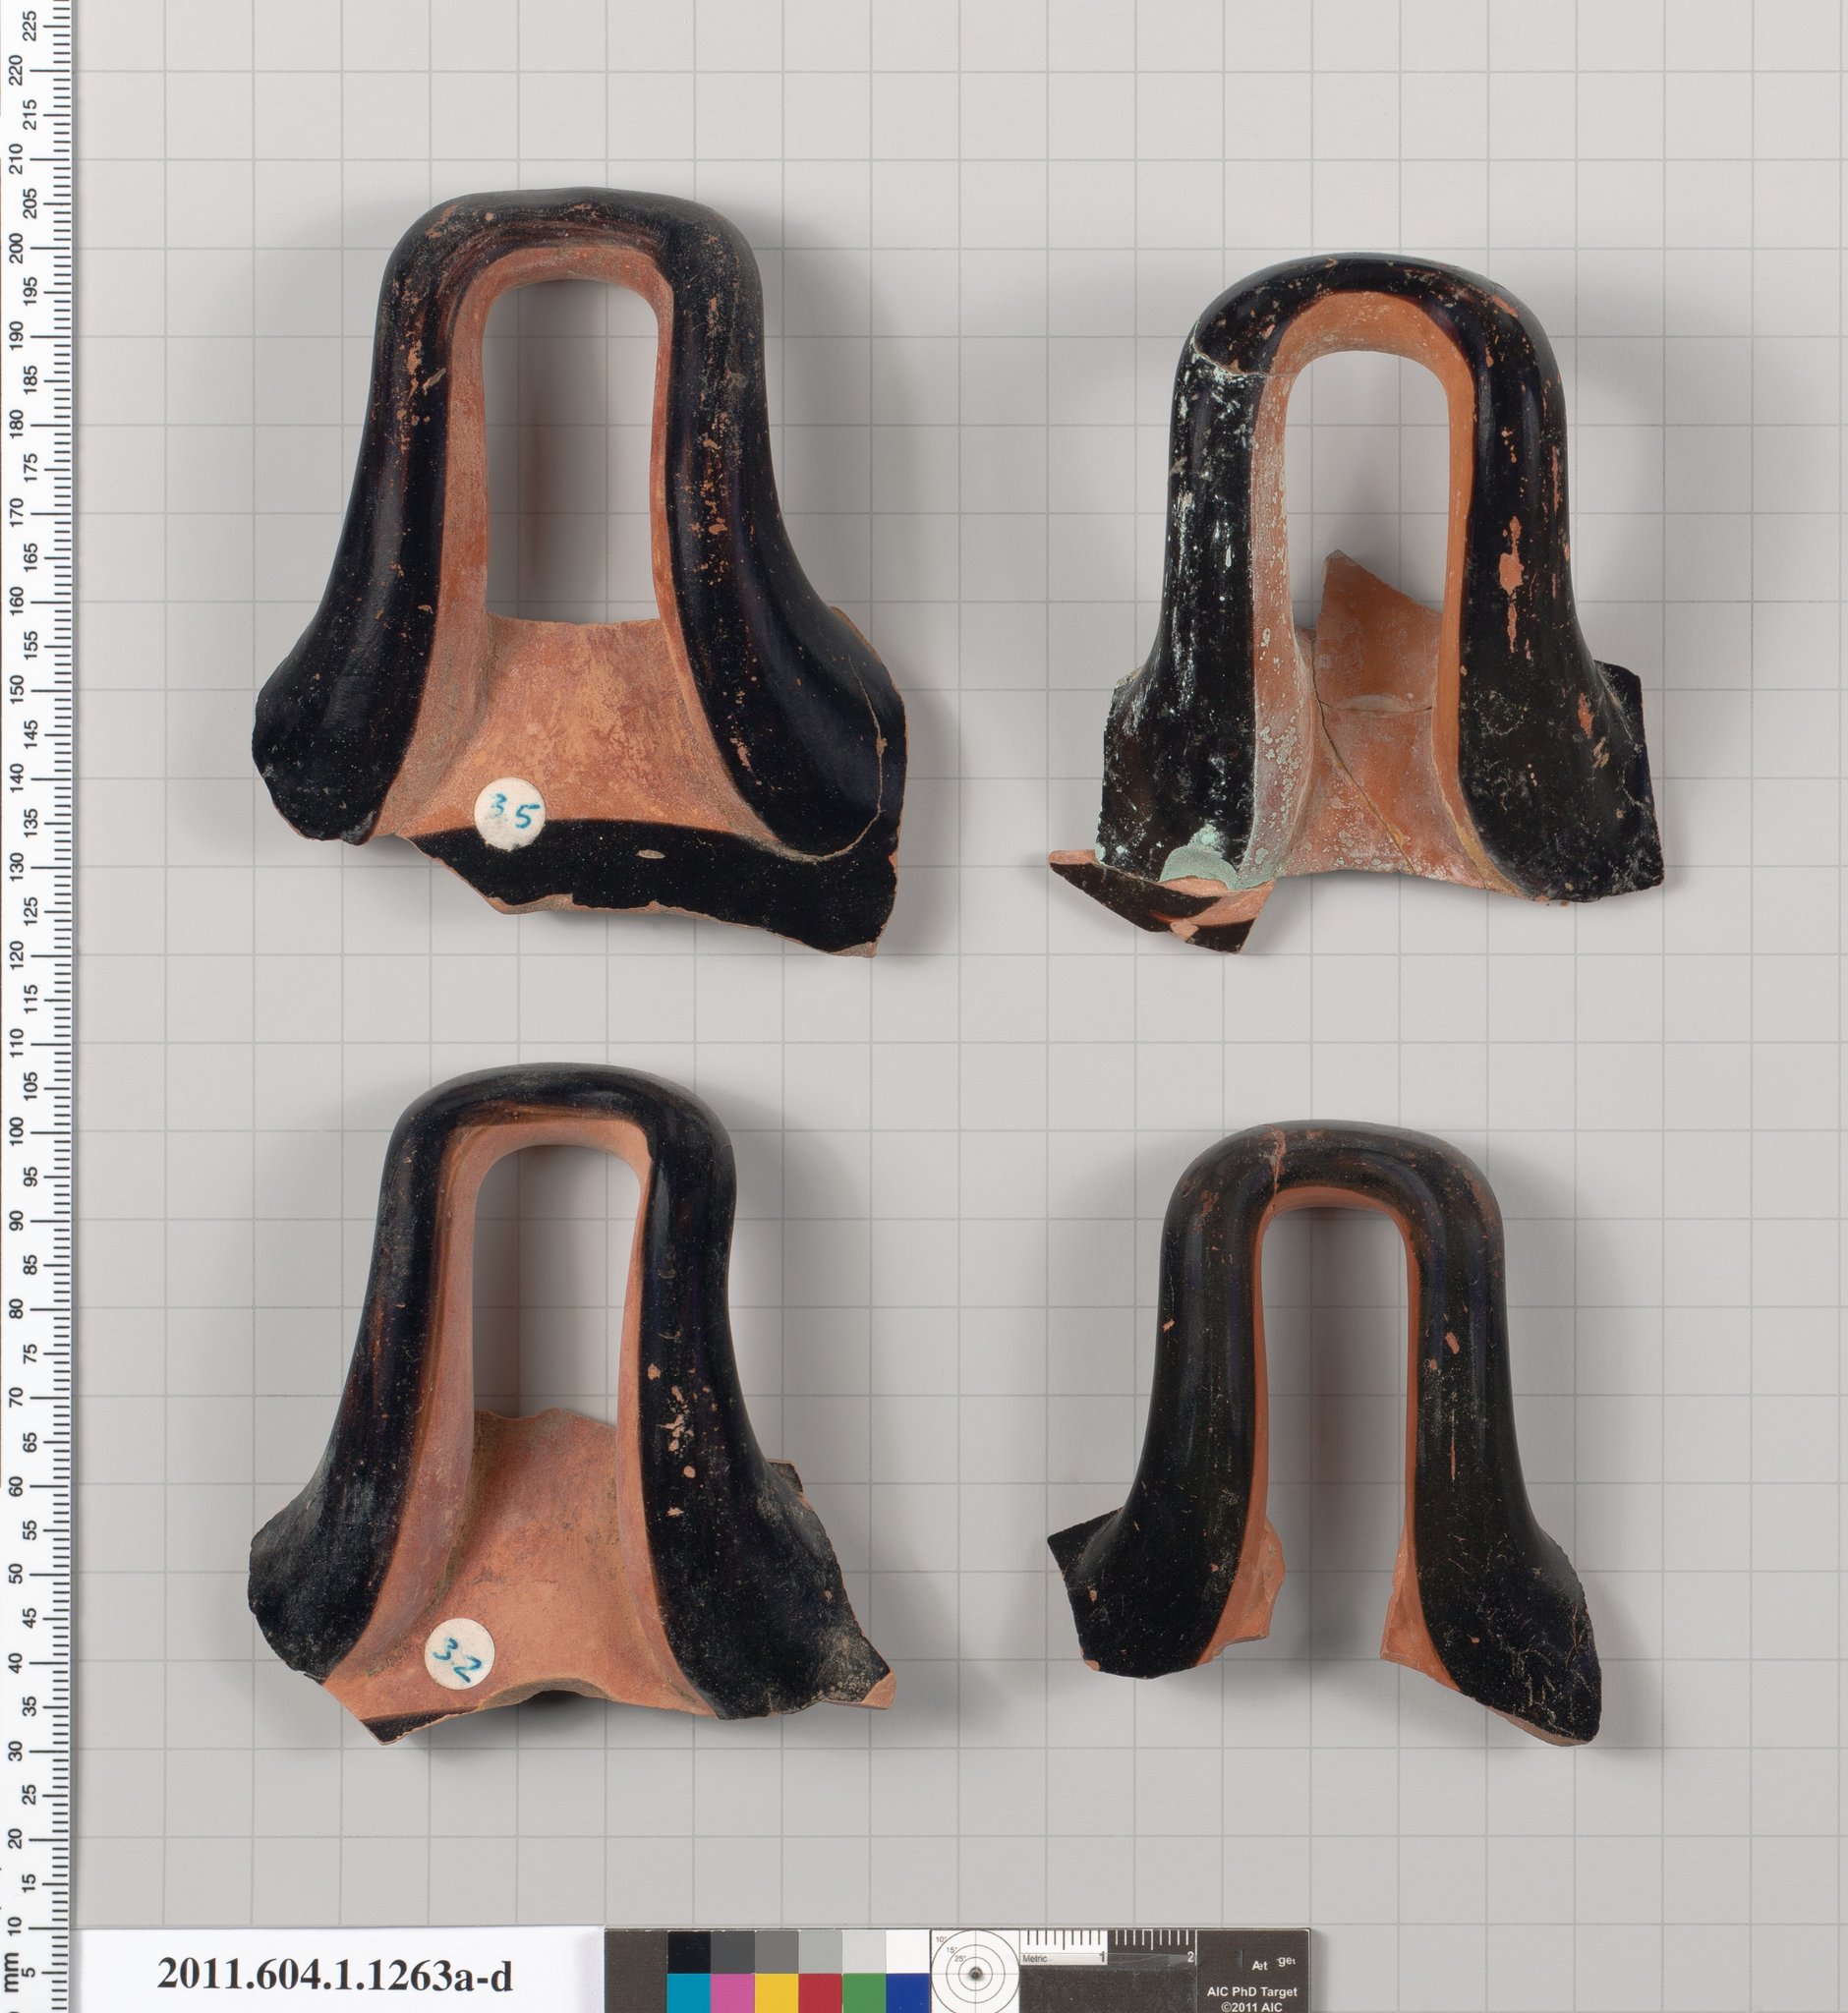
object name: kylix fragment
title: Terracotta fragments of kylikes (drinking cups)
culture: greek, attic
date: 500-401 BCE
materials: terracotta